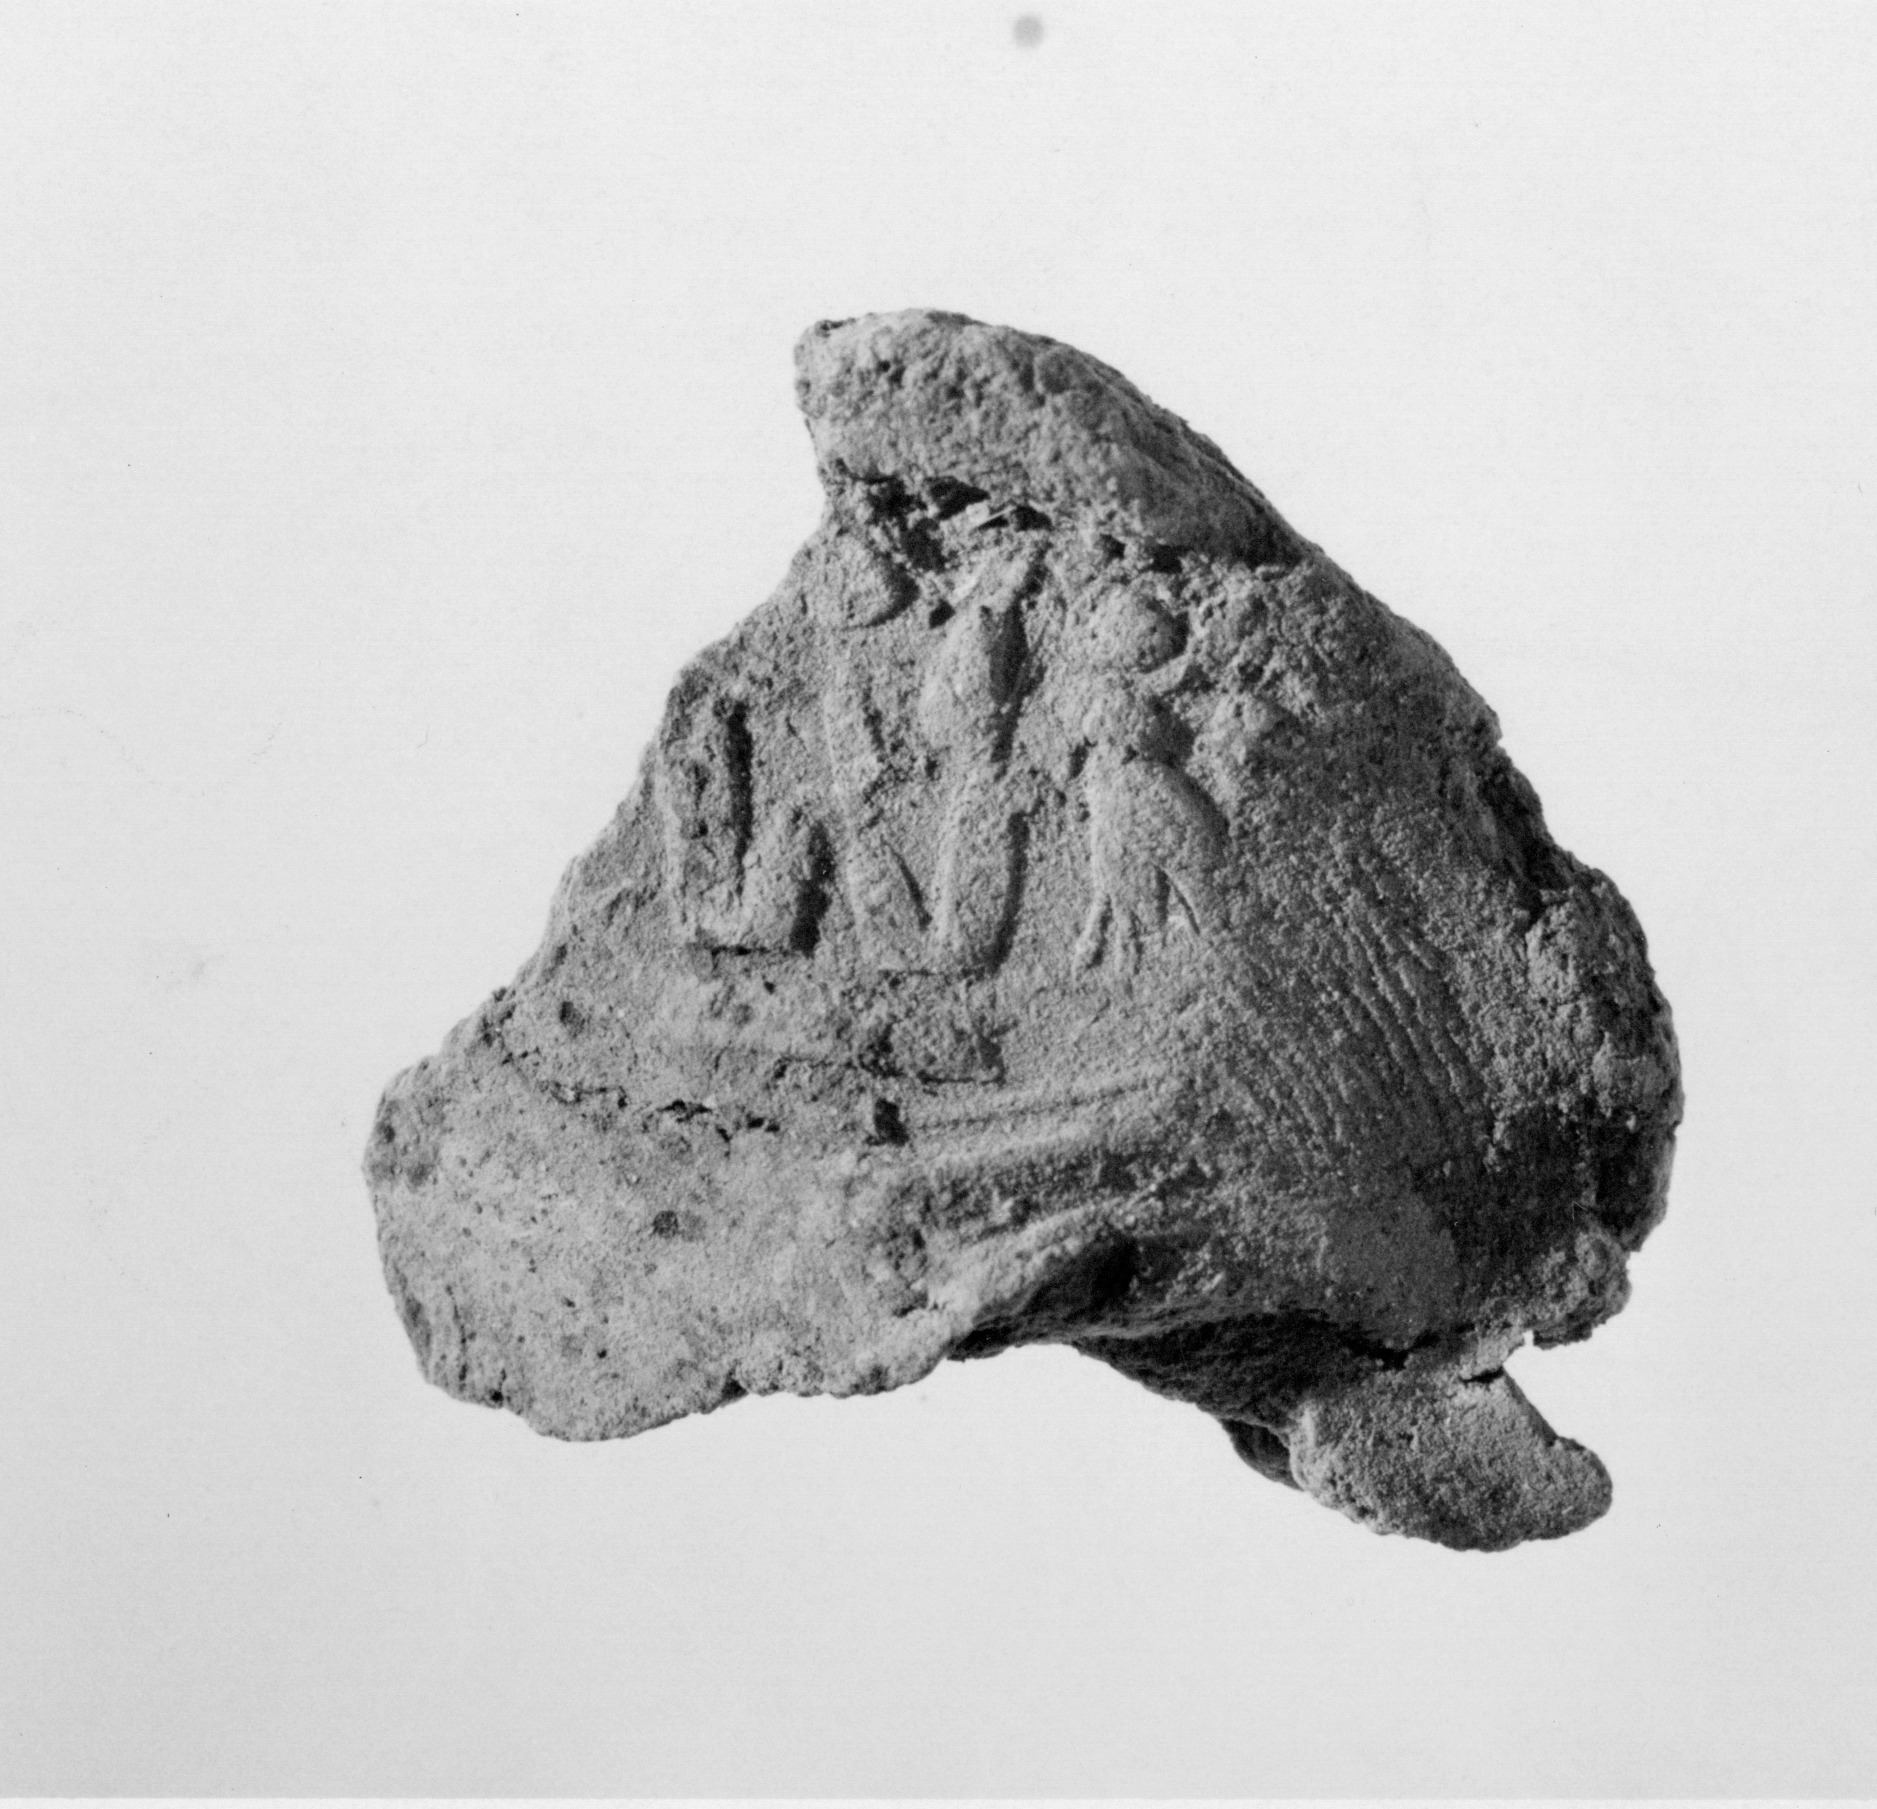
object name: sealing, nebmaatre, amenhotep iii, horus, re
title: Document Sealing With the Throne Name of Amenhotep III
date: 1390-1352 BCE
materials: mud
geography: egypt